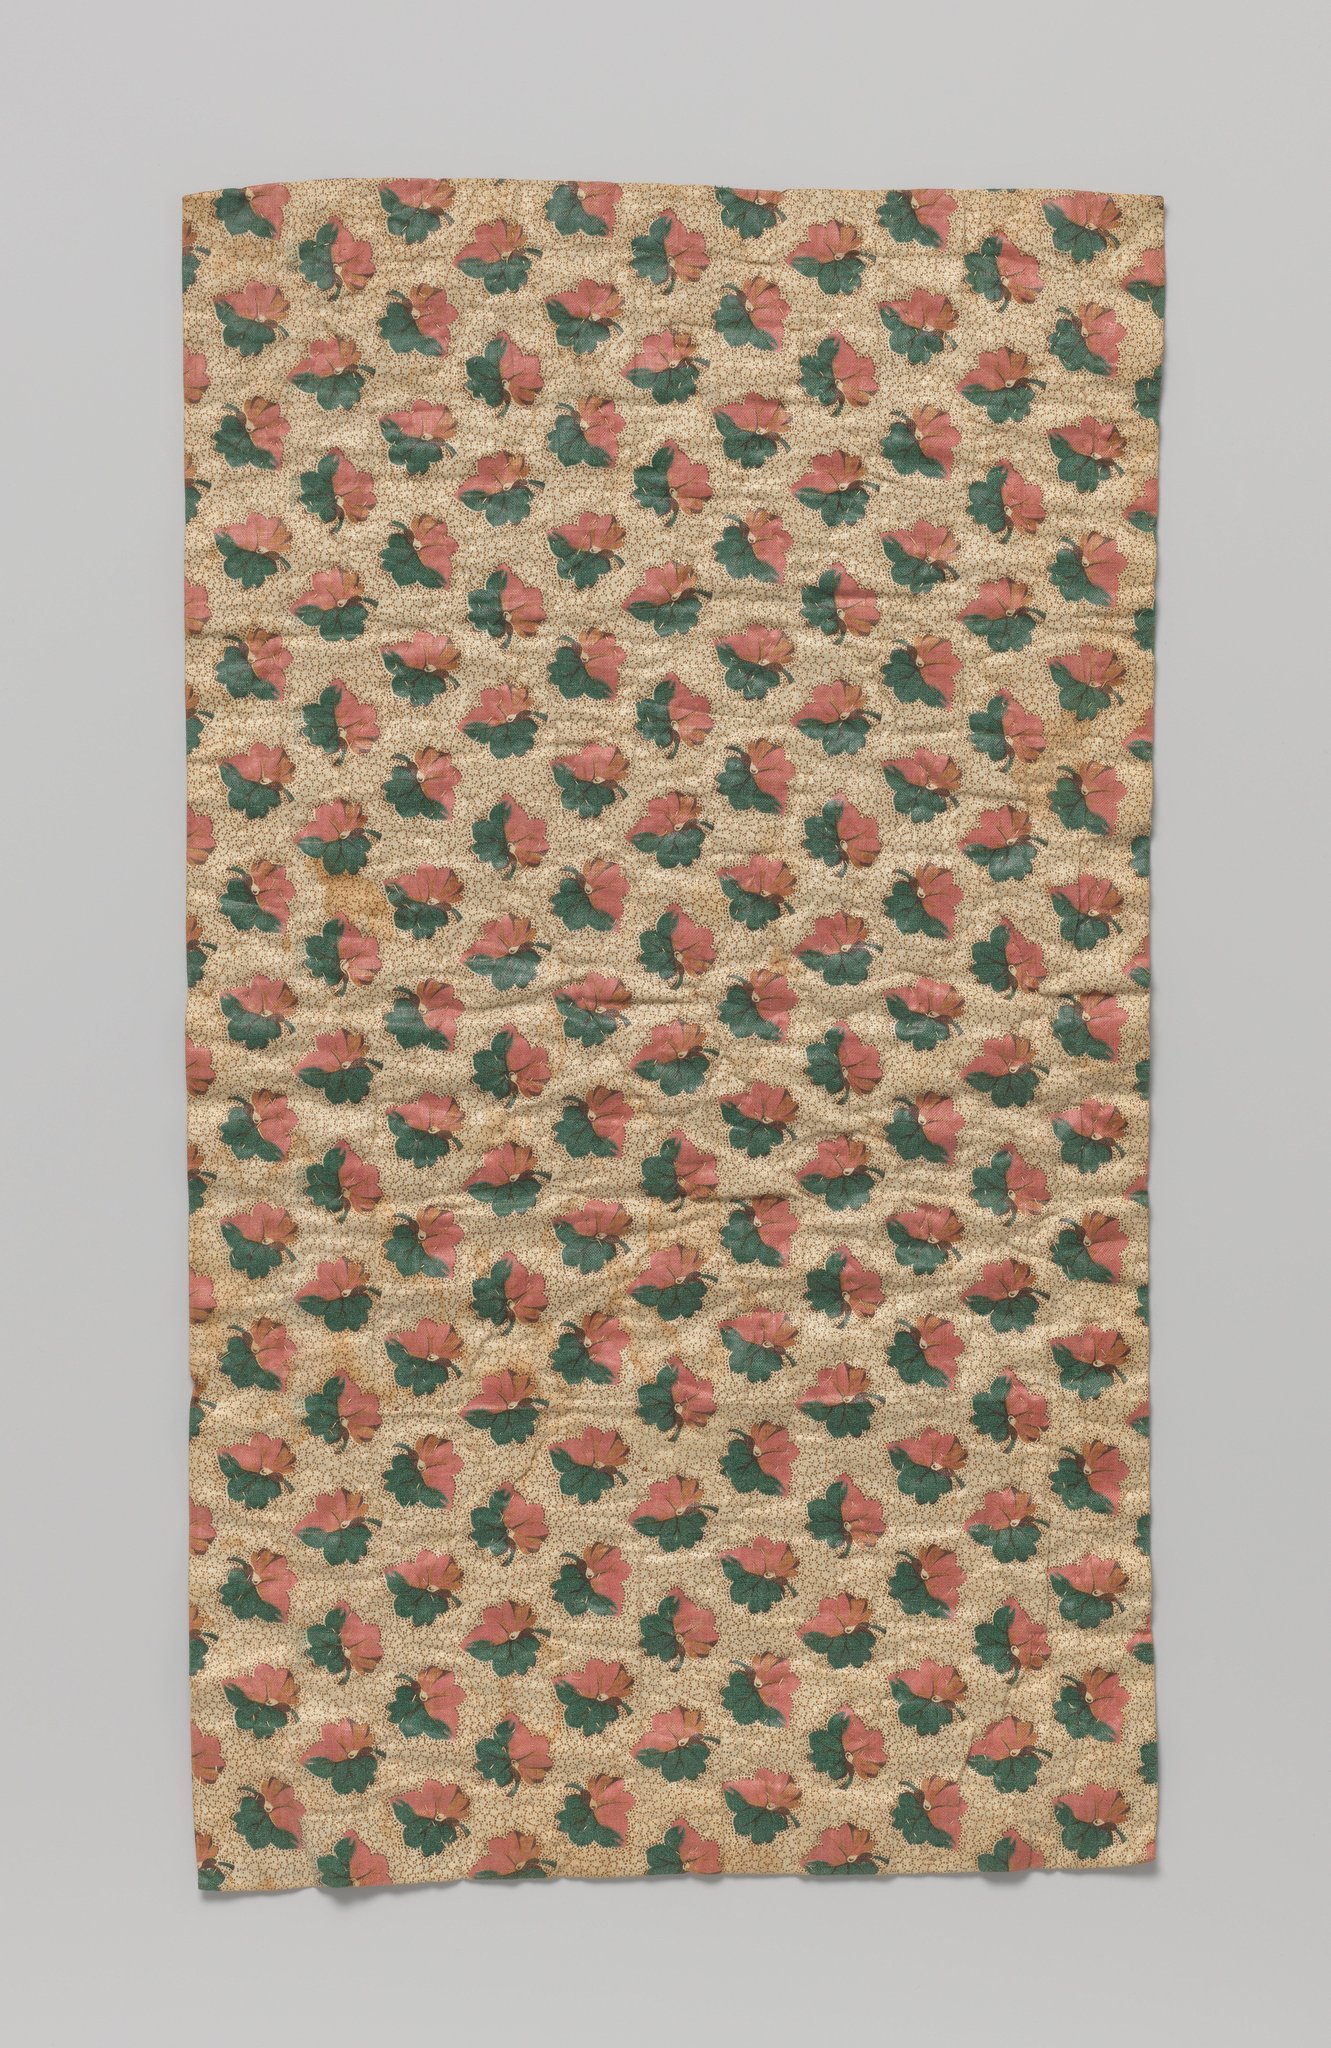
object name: poppengoed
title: Rechthoekige doek met bladpatroon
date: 1836-1898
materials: textile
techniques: weave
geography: netherlands